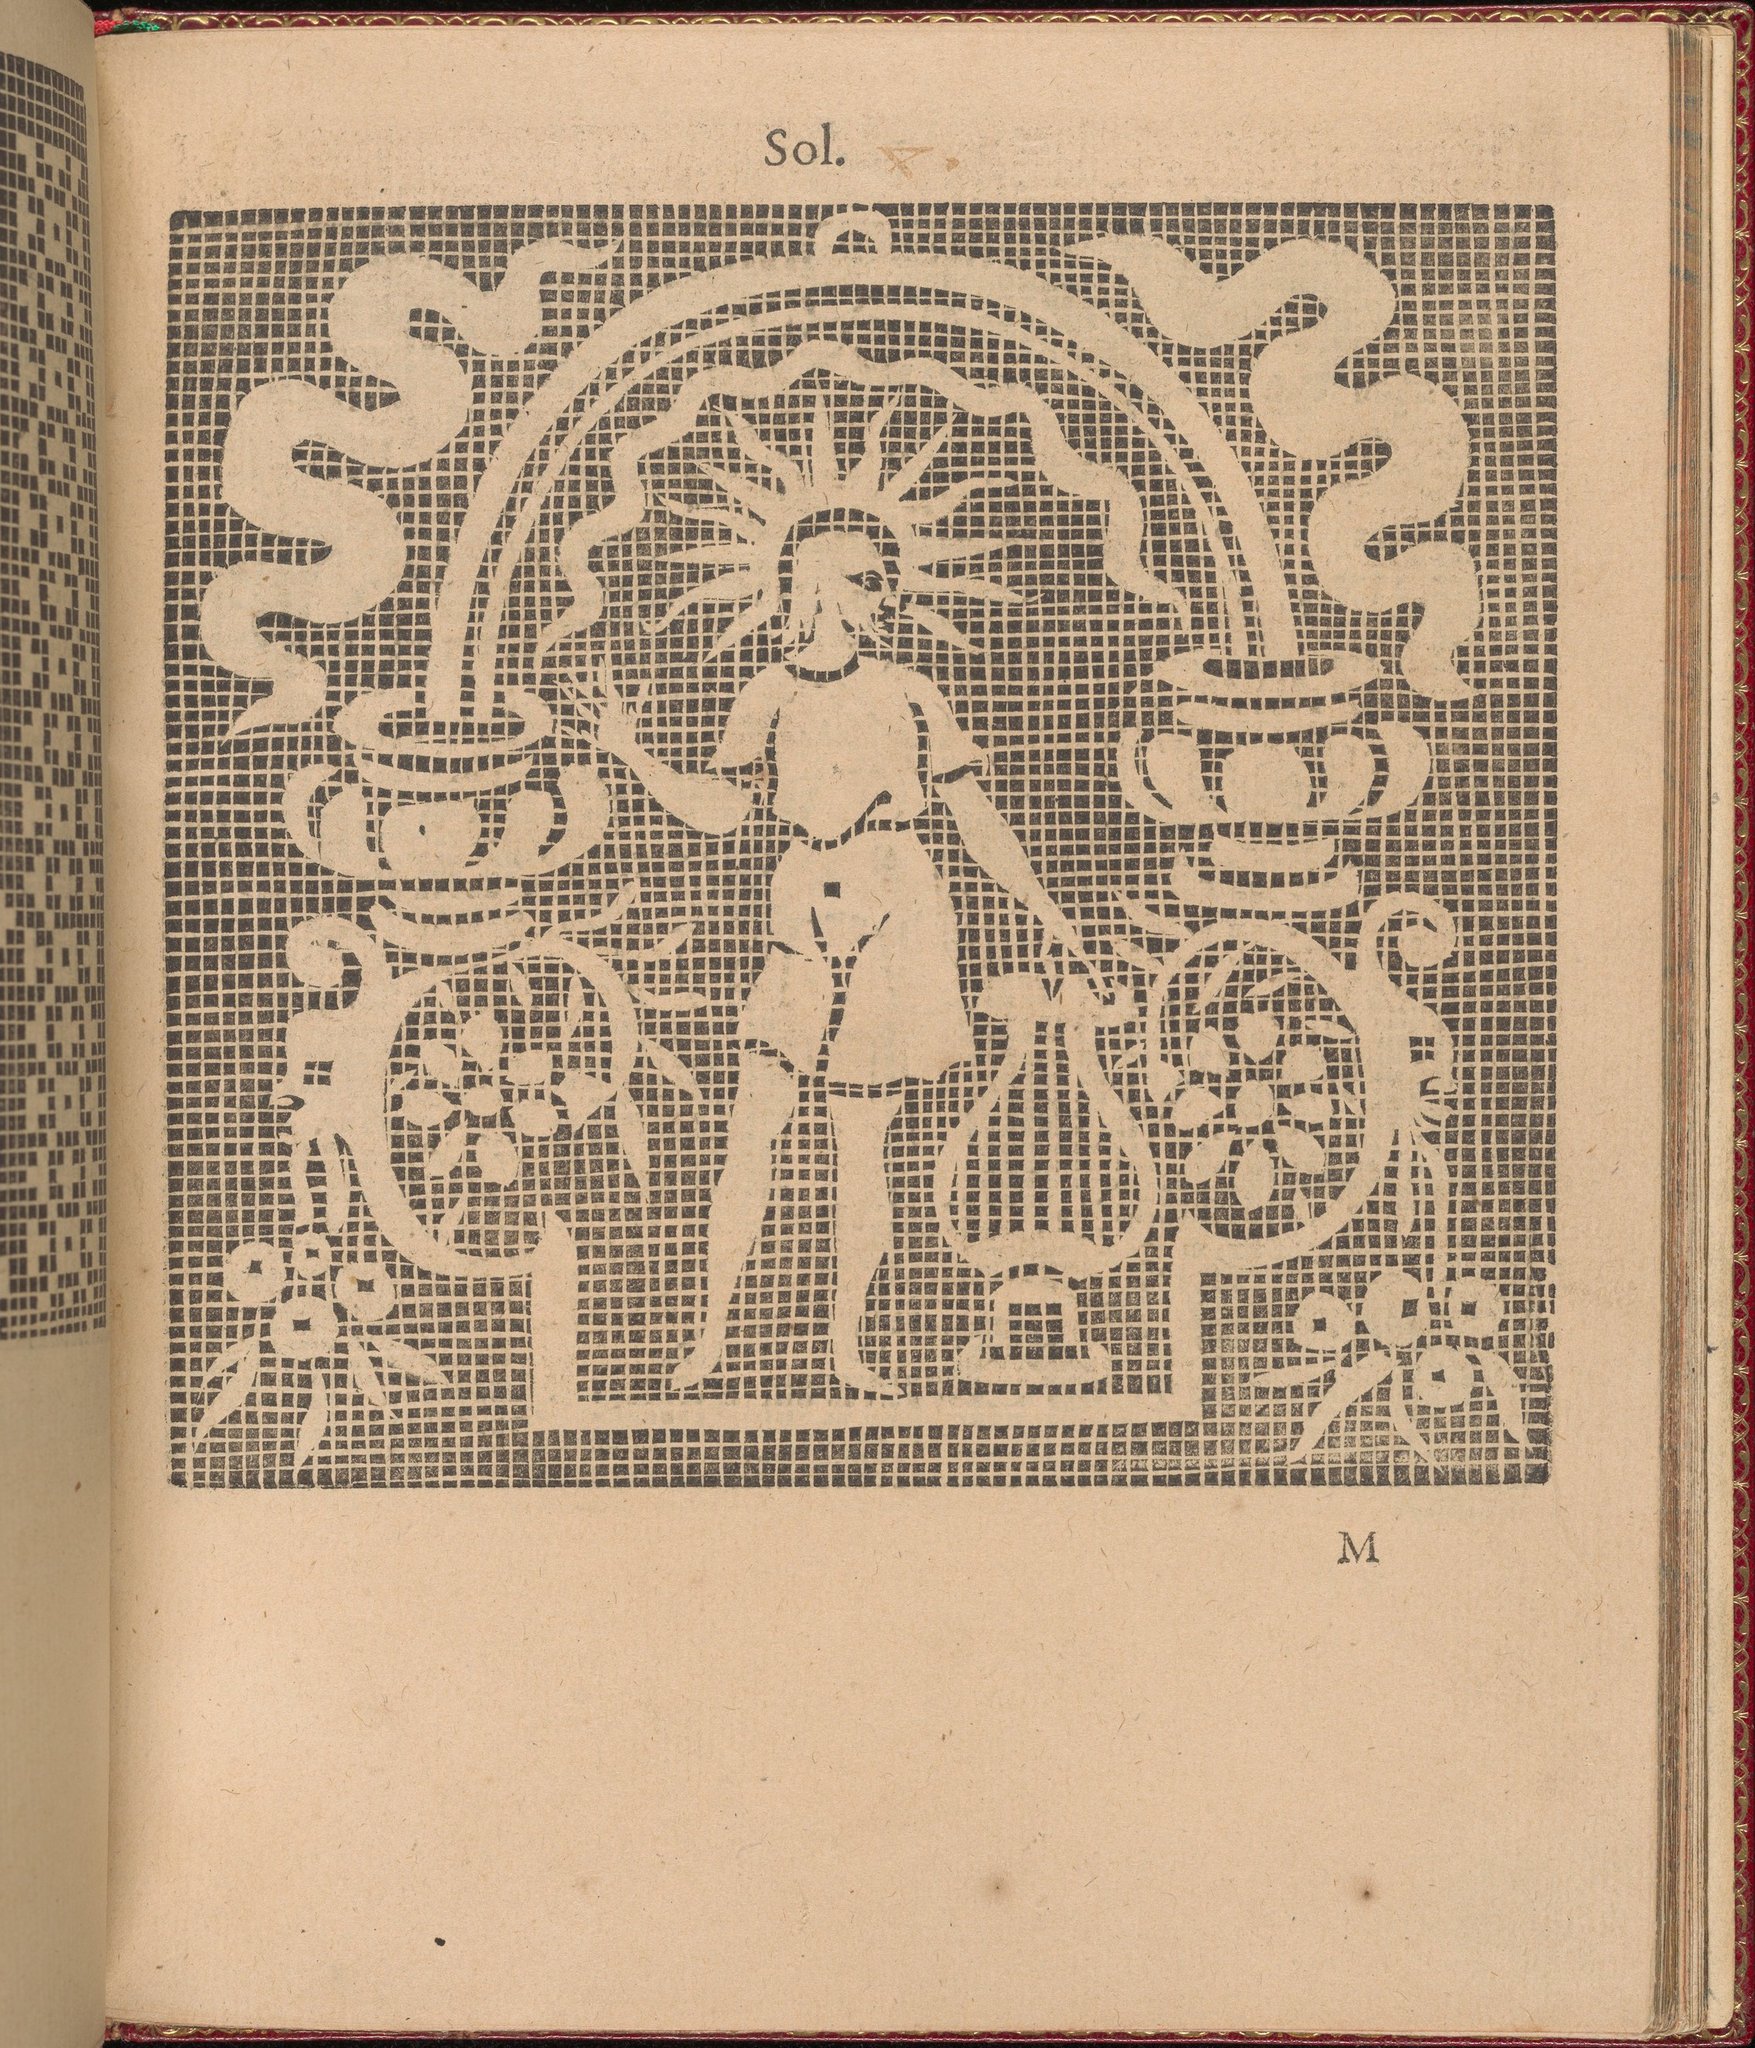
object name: book print ornament architecture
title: Les Singuliers et Nouveaux Portraicts... page 45 (recto)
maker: federico de vinciolo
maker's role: designer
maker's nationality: italian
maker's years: 1582-1599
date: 1588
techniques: woodcut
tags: human figures,flowers